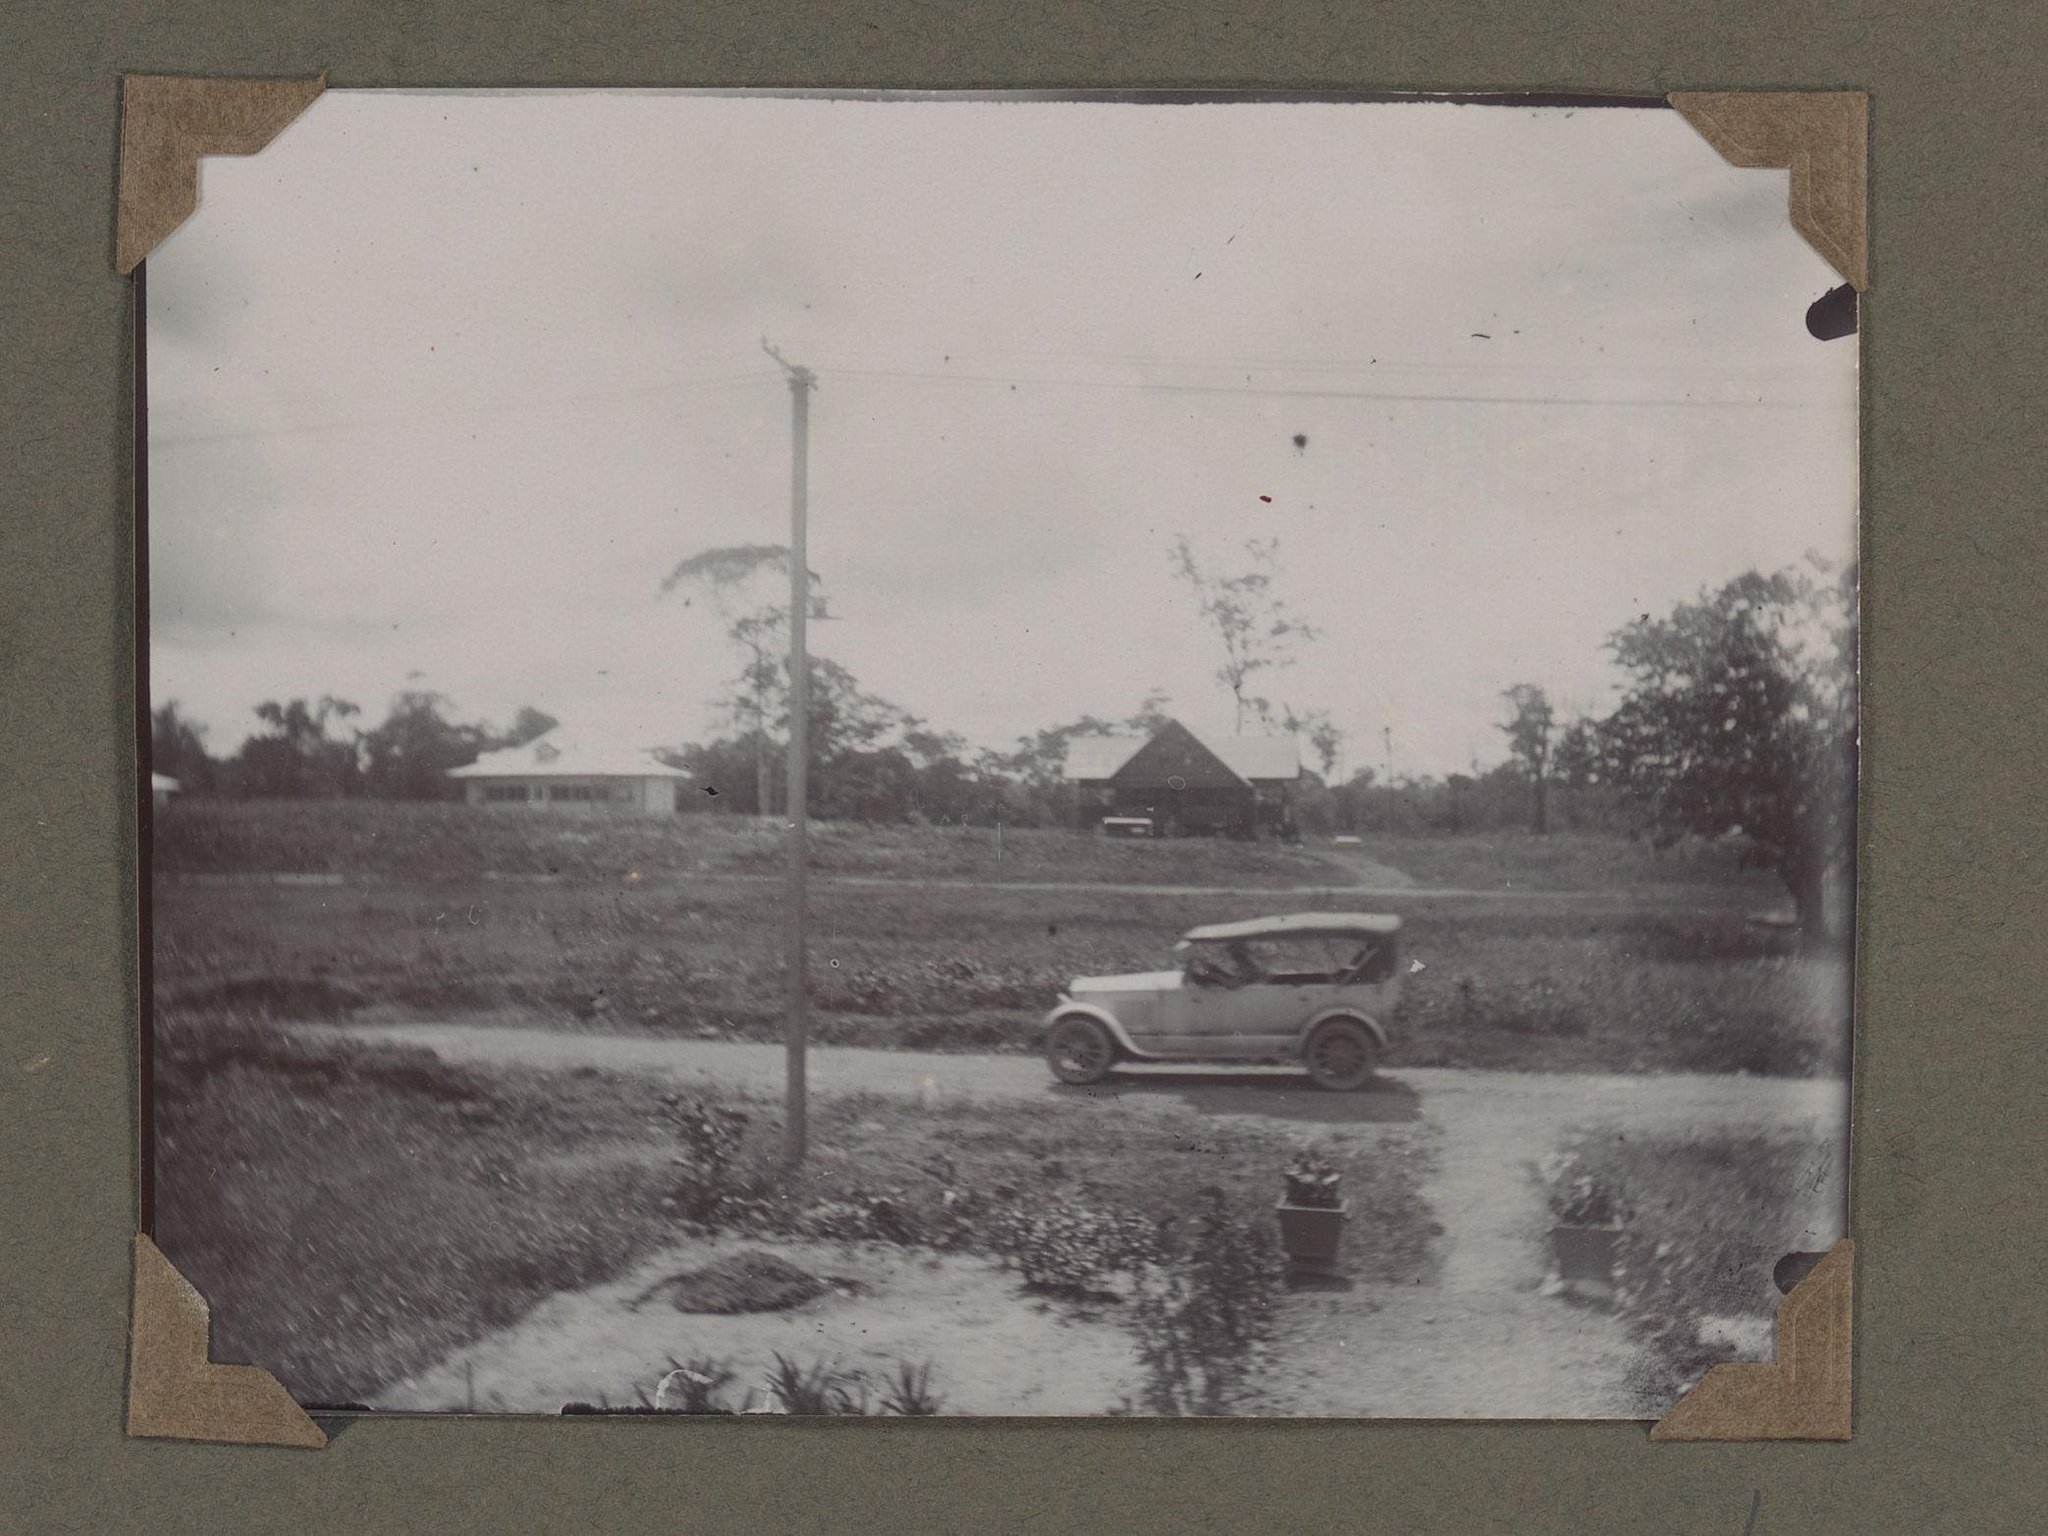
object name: photograph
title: Auto te Moengo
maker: Anonymous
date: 1925-1927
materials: photographic support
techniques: photography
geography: suriname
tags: jetten, familie, moengo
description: Auto te Moengo. Foto op een bladzijde van een los albumblad. Onderdeel van het ensemble met foto's van de familie van ingenieur Jetten in de mijnbouwstad Moengo in Suriname.